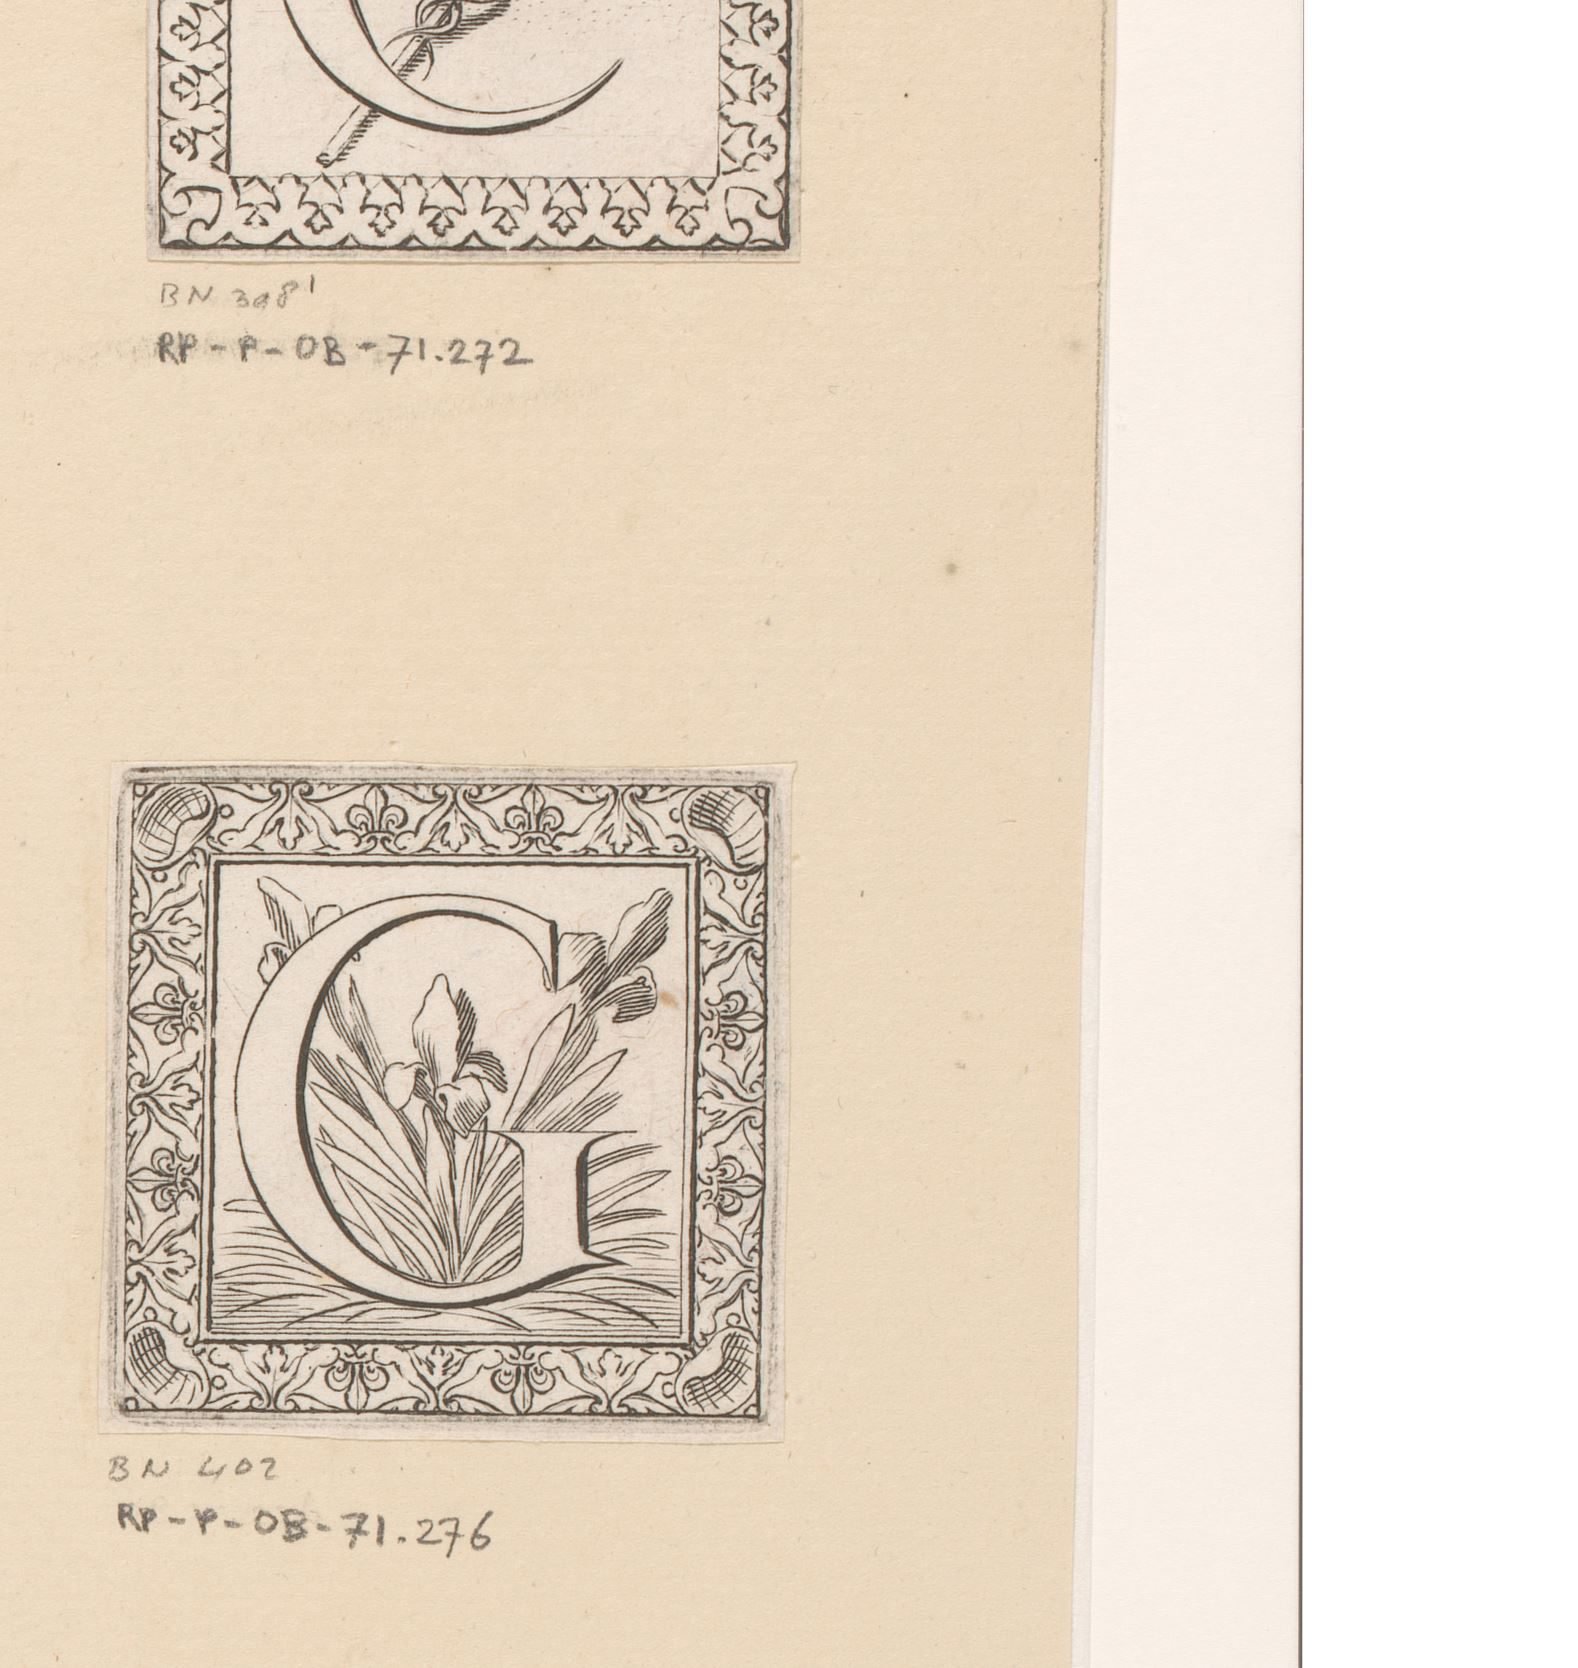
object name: print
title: Letter G met fleurs de lis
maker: claude mellan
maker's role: draughtsman, print maker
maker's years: 1598-1688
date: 1639-1643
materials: paper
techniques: engraving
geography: paris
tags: fleur-de-lis ~ ornament, decoration of printed matter, letters, alphabet, script, flowers: lily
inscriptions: collector's mark: Lugt 240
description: Dit betreft één van de 21 letters die Mellan voor de Imprimerie Royale vervaardigde. Elke letter wordt vergezeld door een afbeelding van een onderwerp dat met dezelfde letter begint. Tussen 1639-1643 werkte Mellan samen met de Imprimerie Royale (IFF 17e siècle, p. 21-22). Hij vervaardigde verschillende vignetten, letters, culs-de-lampe en decoratieve banden (IFF 17e siècle, p. 215-220).